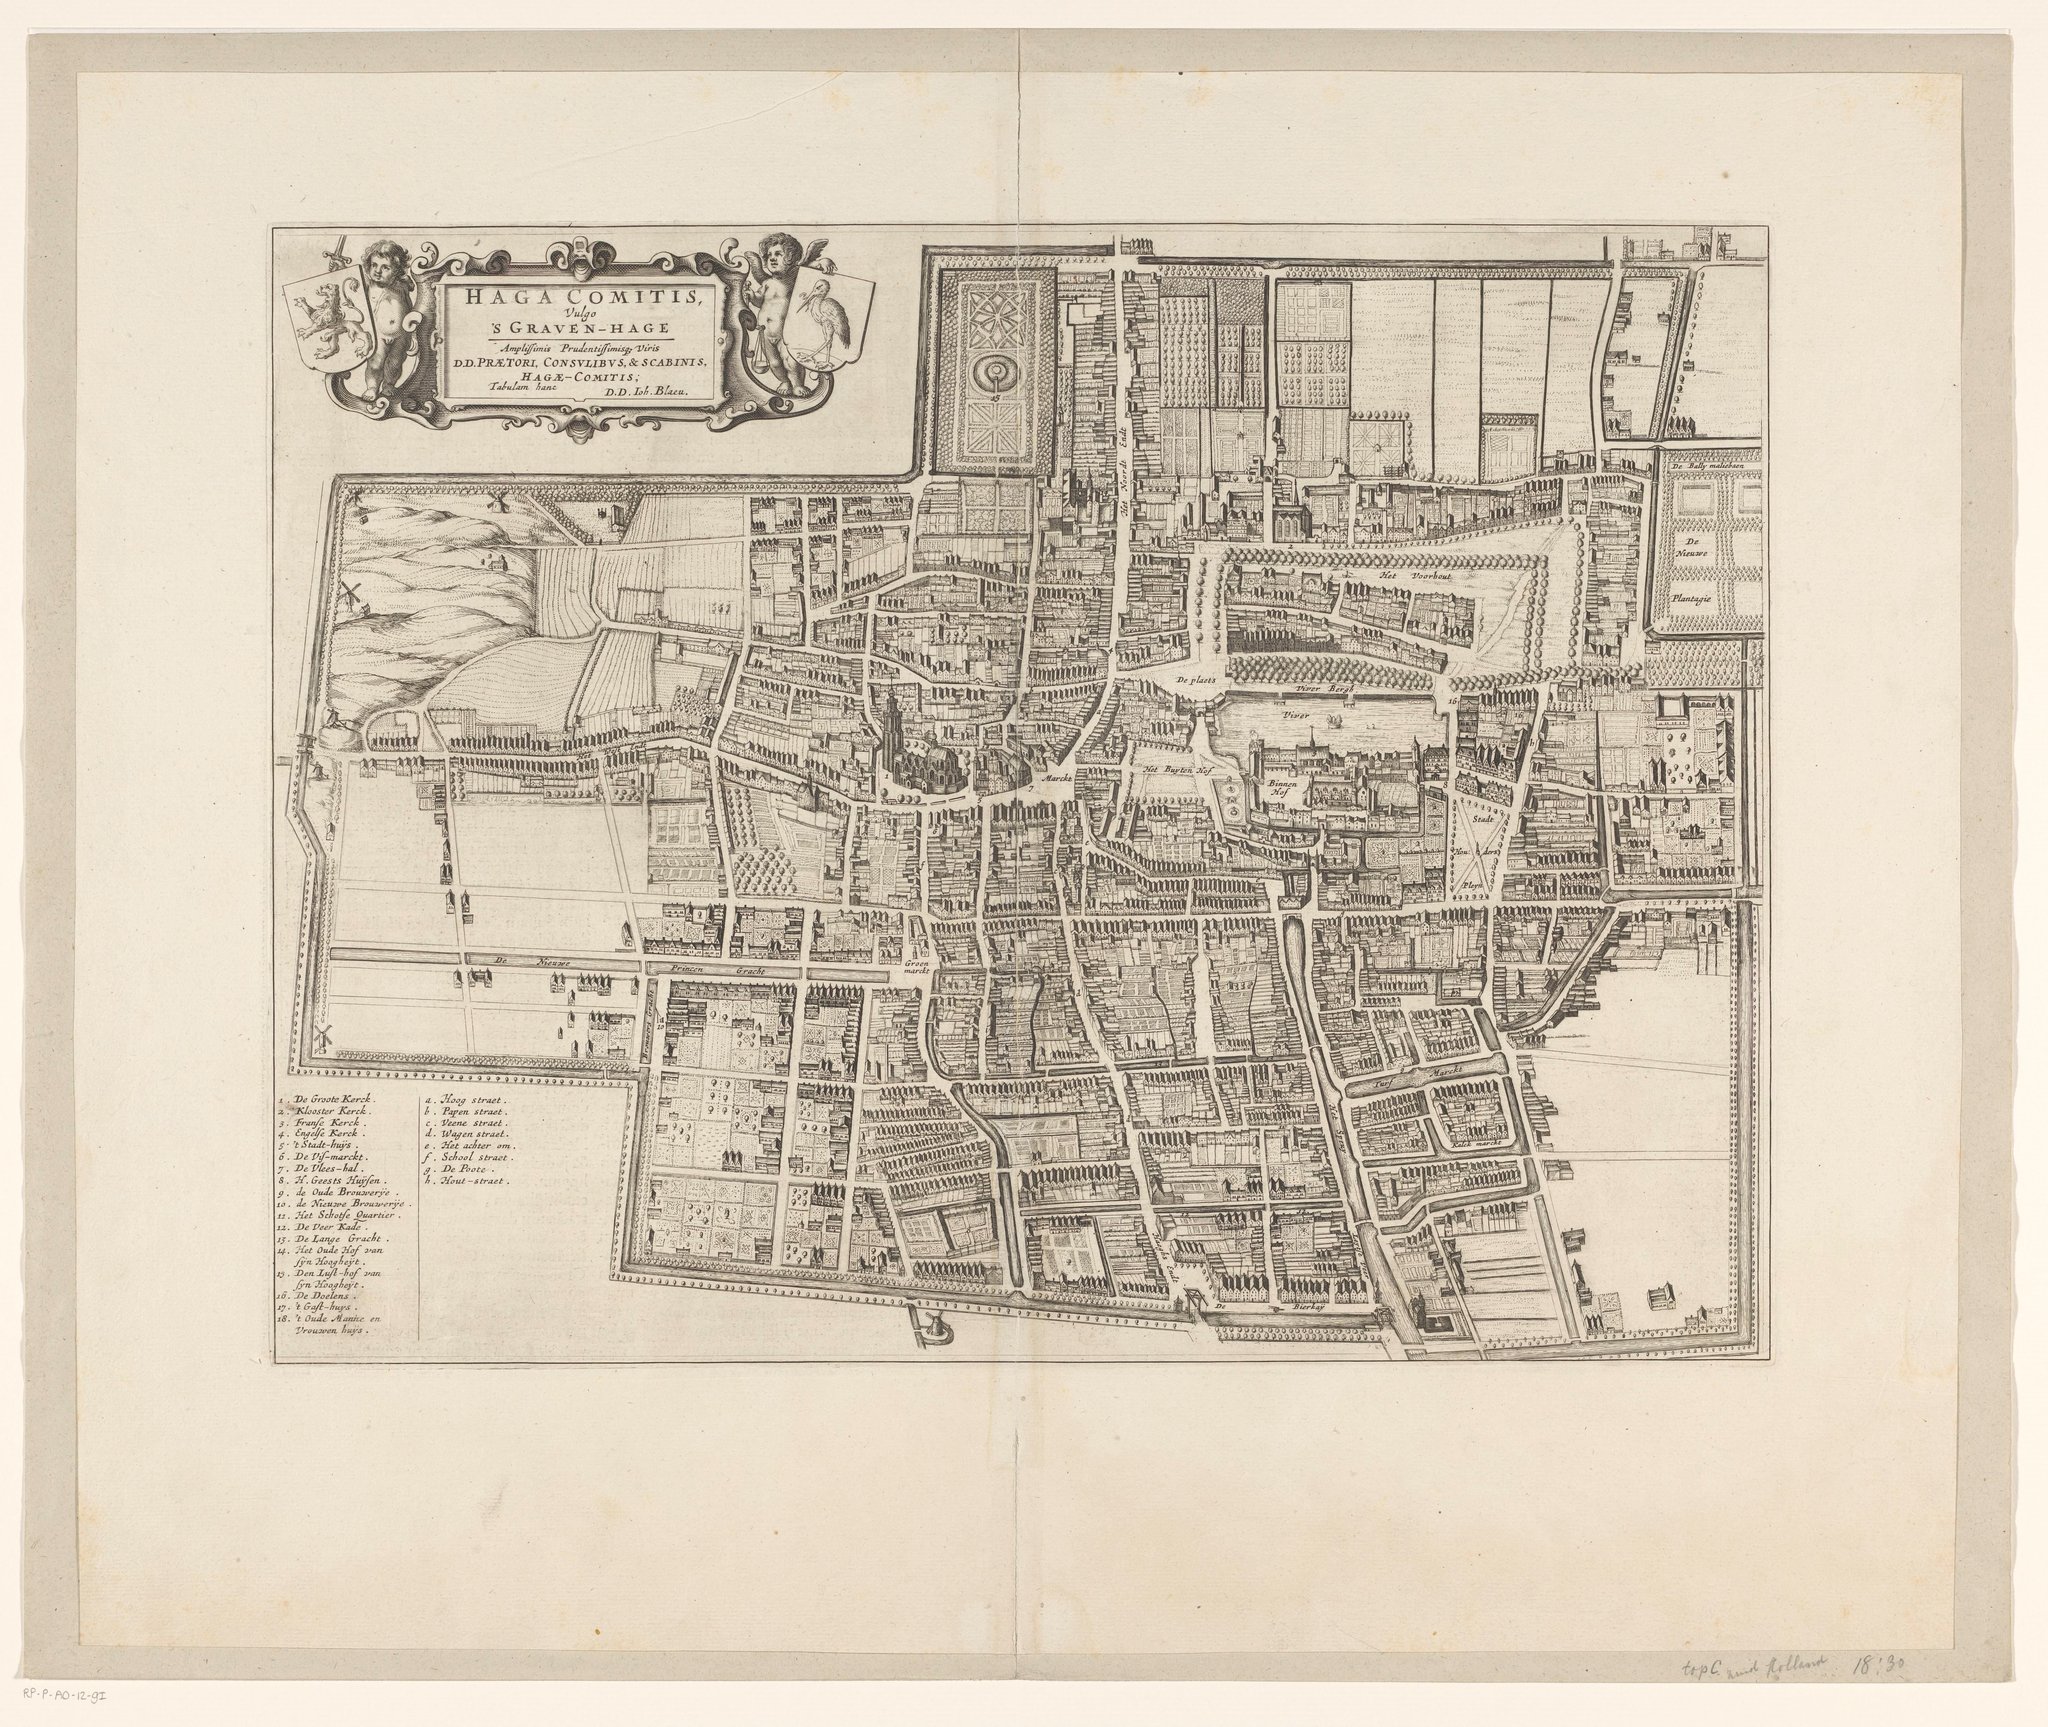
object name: area plan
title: Plattegrond van Den Haag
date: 1652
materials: paper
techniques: engraving, etching, letterpress printing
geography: amsterdam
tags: coat of arms (as symbol of the state, etc.) (+ city; municipal), maps of cities, coat of arms (as symbol of the state, etc.) (+ province; provincial), the hague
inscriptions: collector's mark: Lugt 2228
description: Plattegrond in vogelvluchtperspectief. Linksboven een cartouche met de titel en de opdracht, met links het wapen van Holland en rechts het wapen van Den Haag. Linksonder een legenda 1-18 en a-h. Op verso Latijnse tekst.